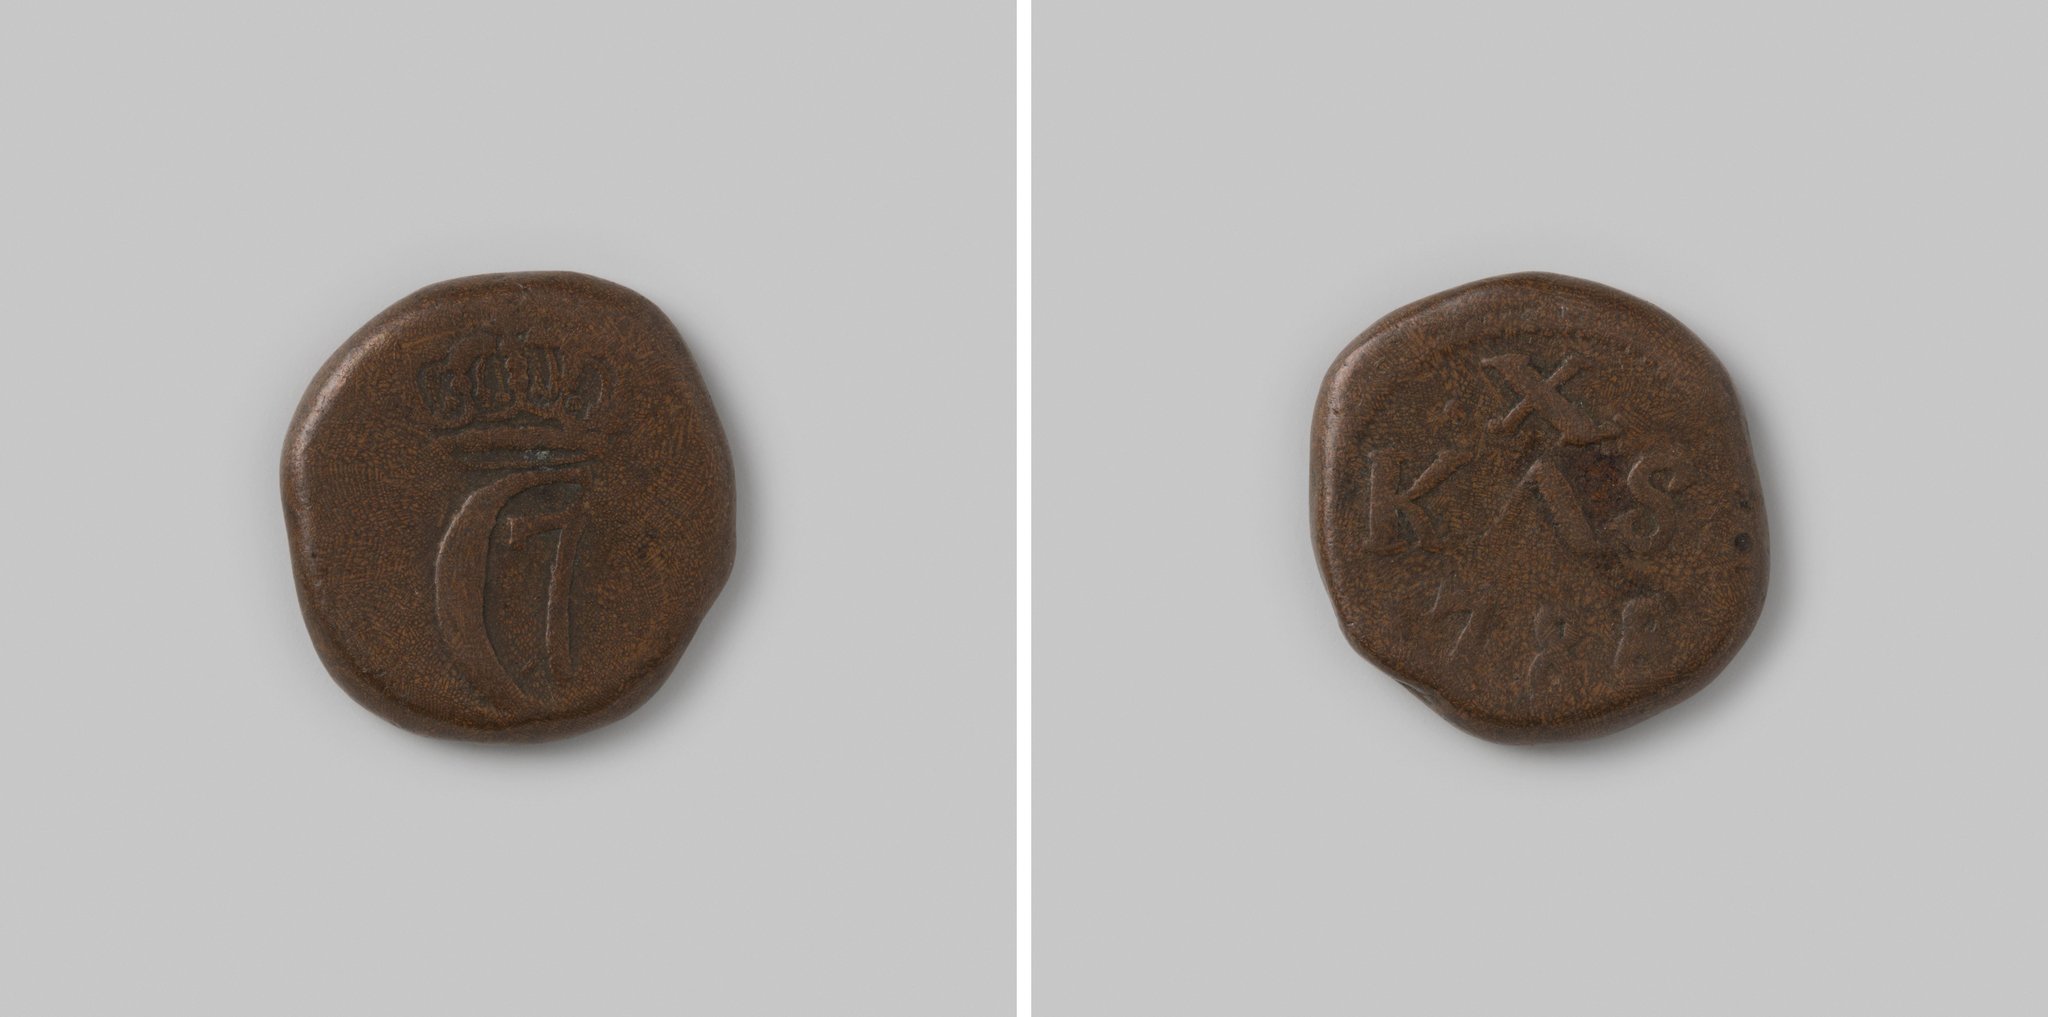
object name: coin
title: Tranquebar, Deens-India, Deense Aziatische Compagnie (DAC) op naam van koning Christiaan VII, 10 kas, 1788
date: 1788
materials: copper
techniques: striking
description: Koperen munt. Voorzijde: gekroond monogram van de koning. Keerzijde: in twee regels waarde-aanduiding: X. kas. Daaronder jaartal.